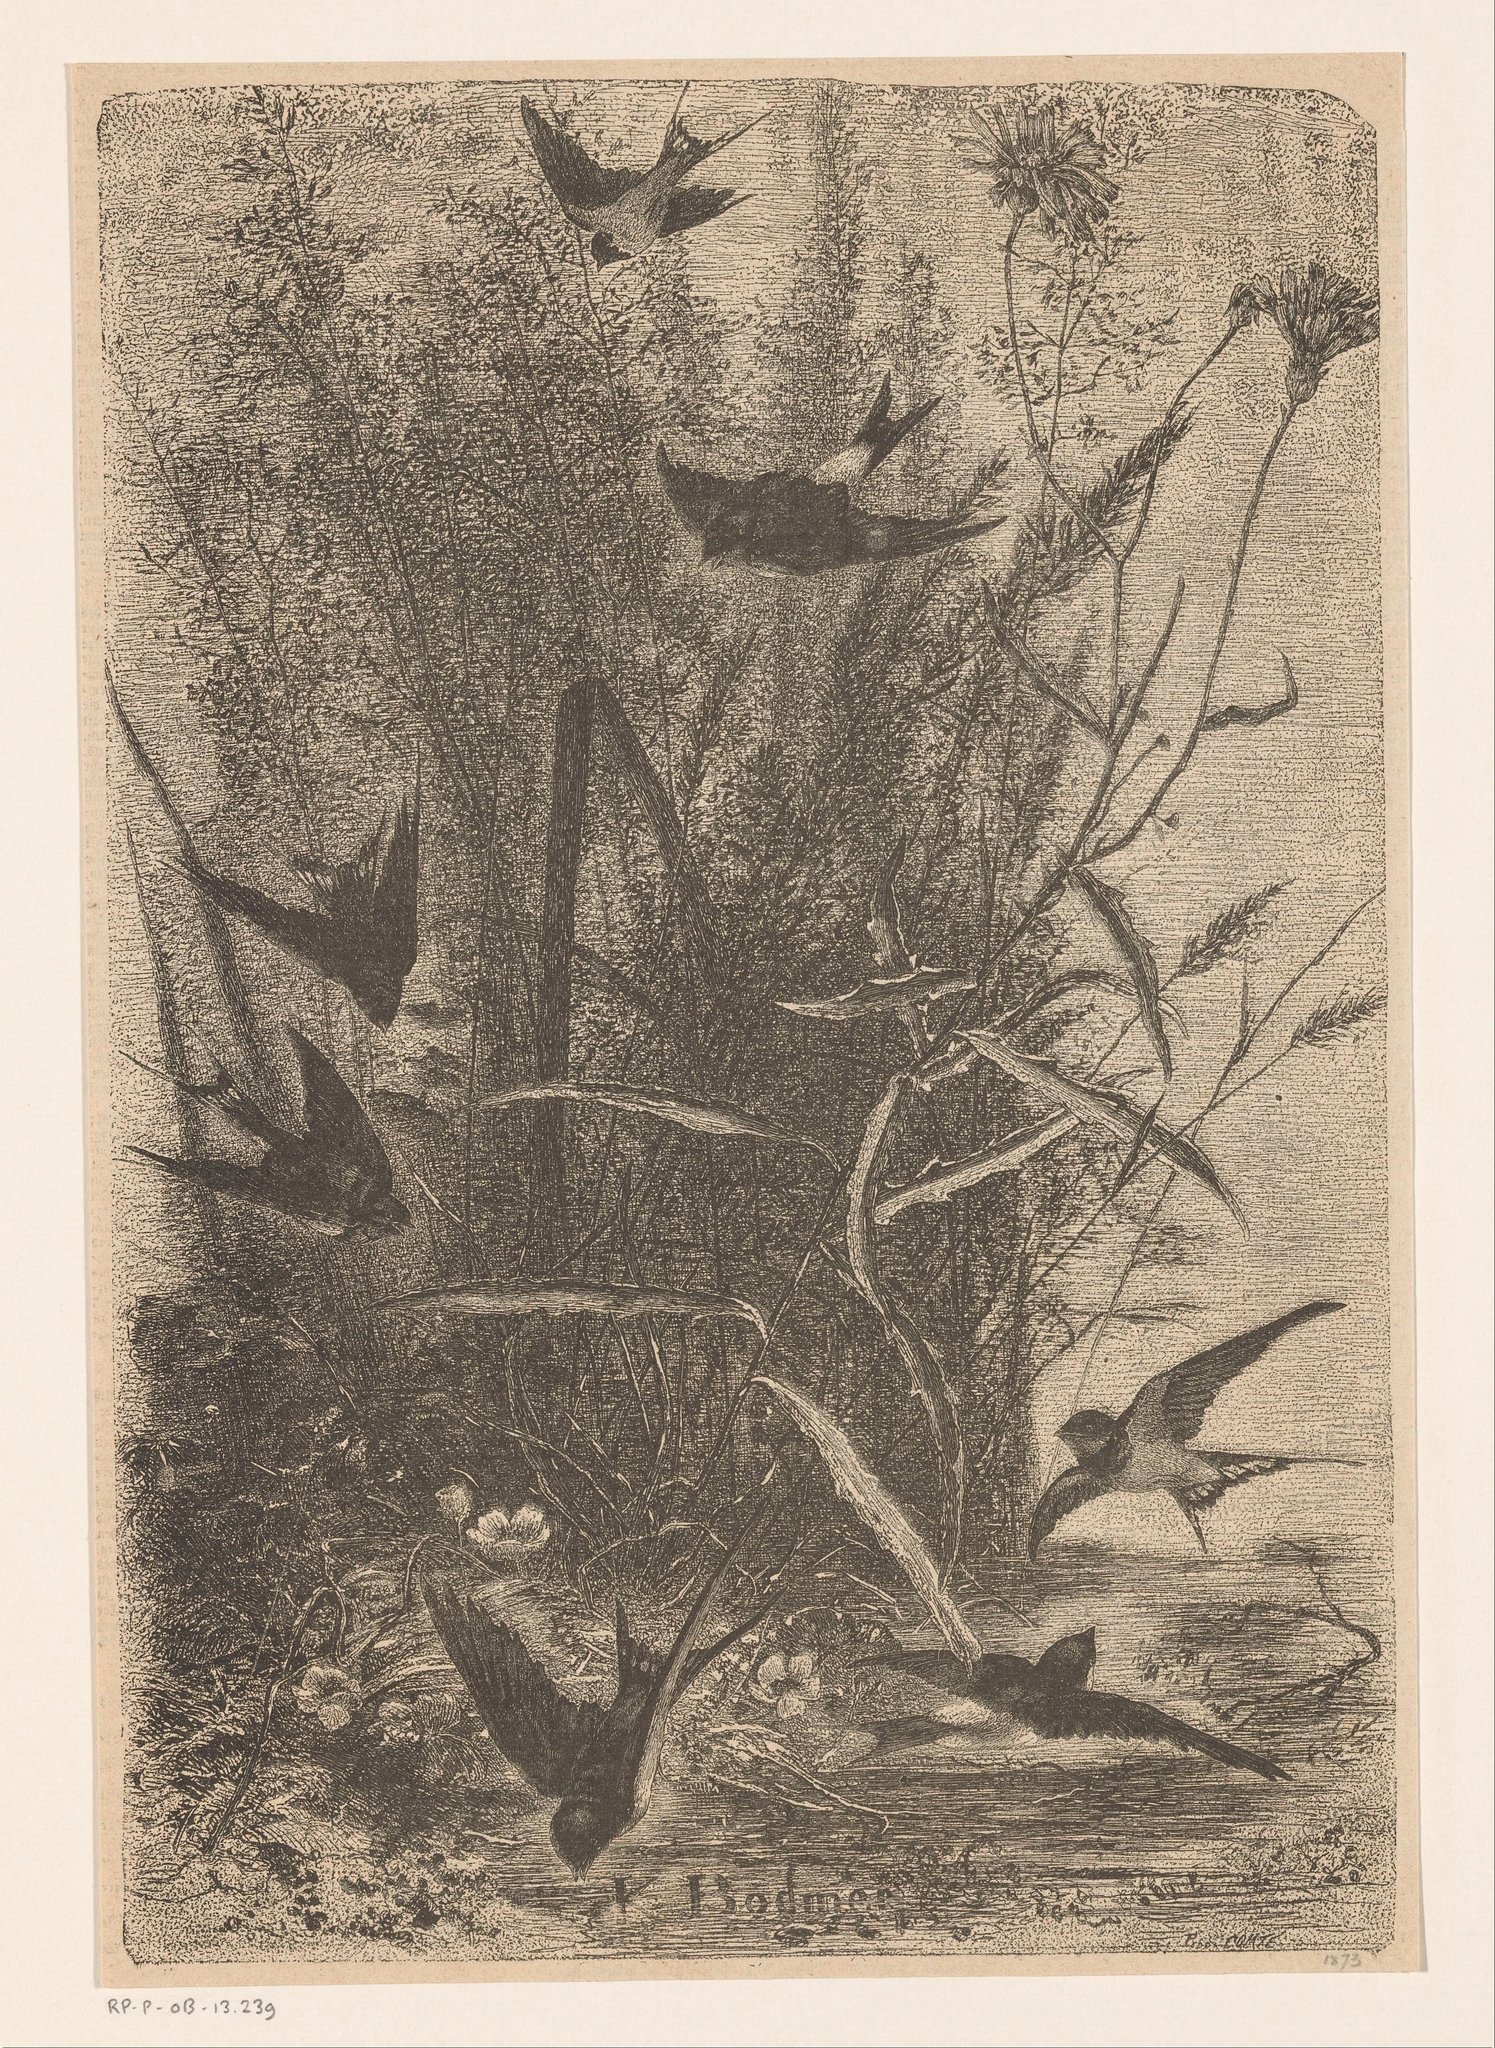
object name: illustration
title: Zwaluwen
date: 1873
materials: paper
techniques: lithography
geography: stuttgart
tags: song-birds: swallow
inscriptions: collector's mark: Lugt 2228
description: Prent waarschijnlijk afkomstig uit: Über Land und Meer. Allgemeine illustrirte Zeitung. Stuttgart: Eduard Hallberger, 1873.